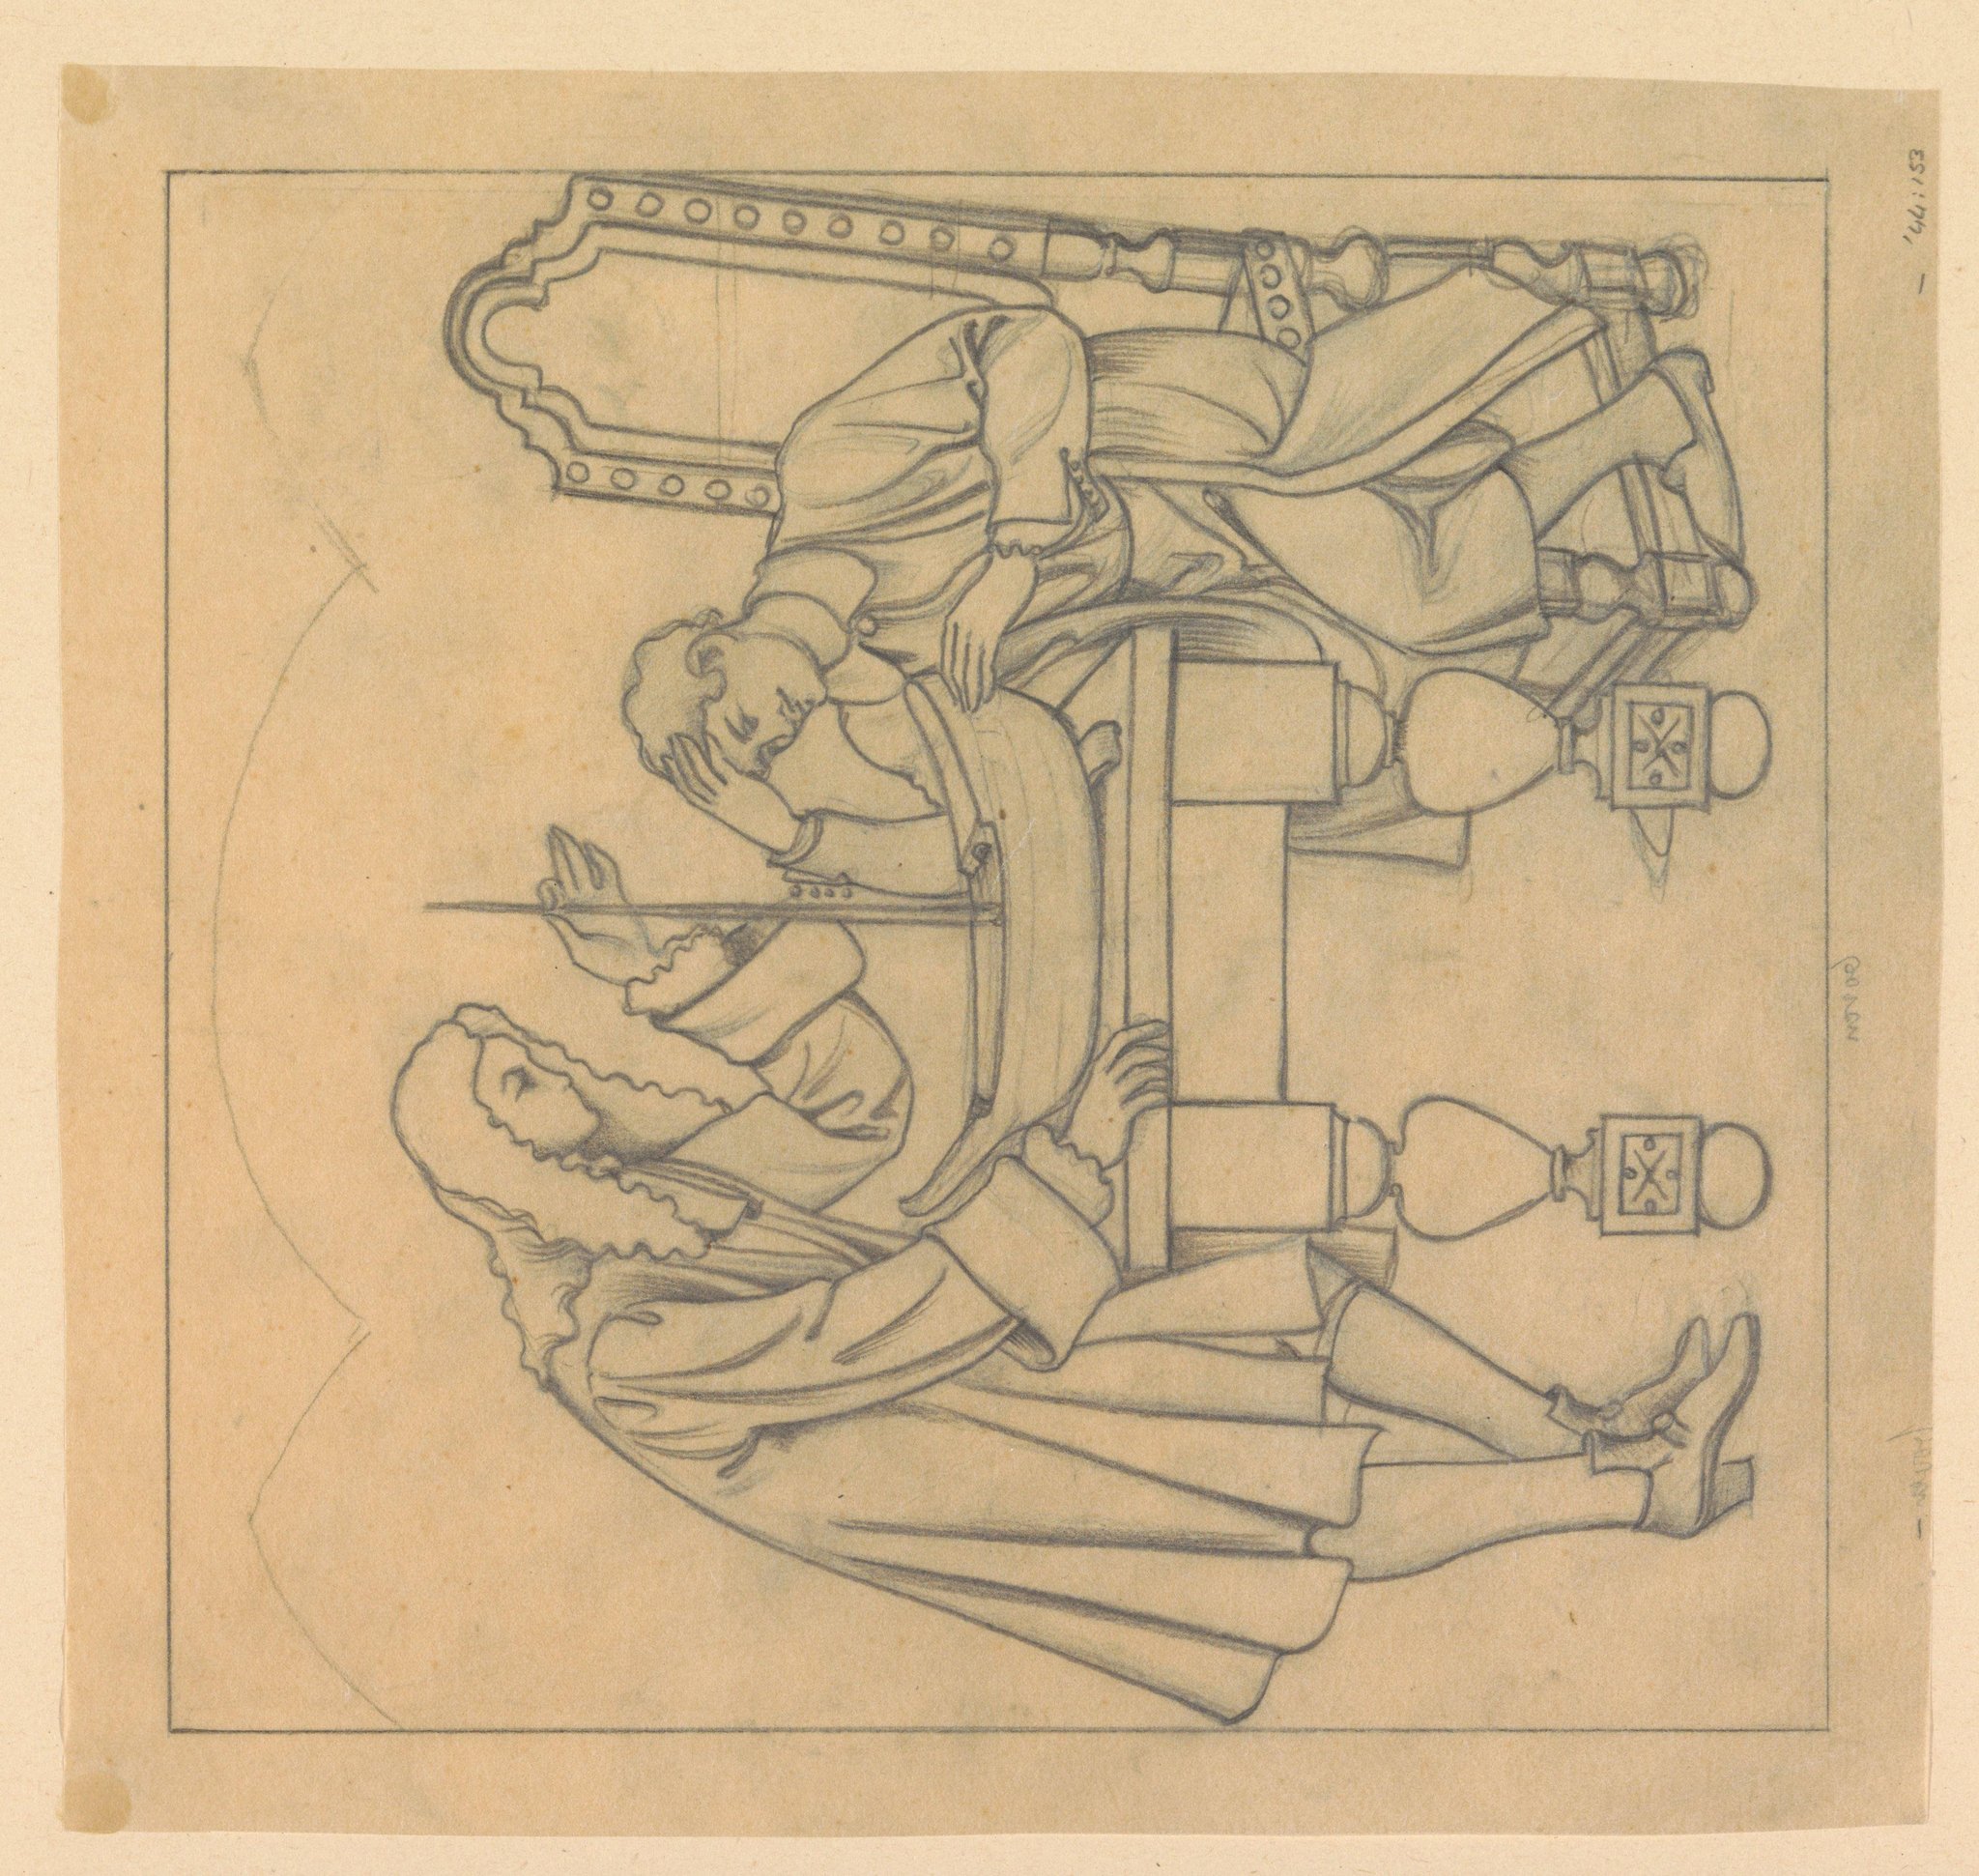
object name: tracing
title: Ontwerp voor wandschildering in de Beurs van Berlage: tsaar Peter de Grote, die door burgemeester Nicolaas Witsen in de zeevaartkunde wordt onderwezen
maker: antoon derkinderen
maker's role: draughtsman, painter, print maker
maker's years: 1859-1925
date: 1869-1925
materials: pencil, paper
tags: amsterdam, print maker, mayor, nicolaes cornelisz. witsen, peter i de grote (tsaar van rusland), mayor, burgomaster, historical persons